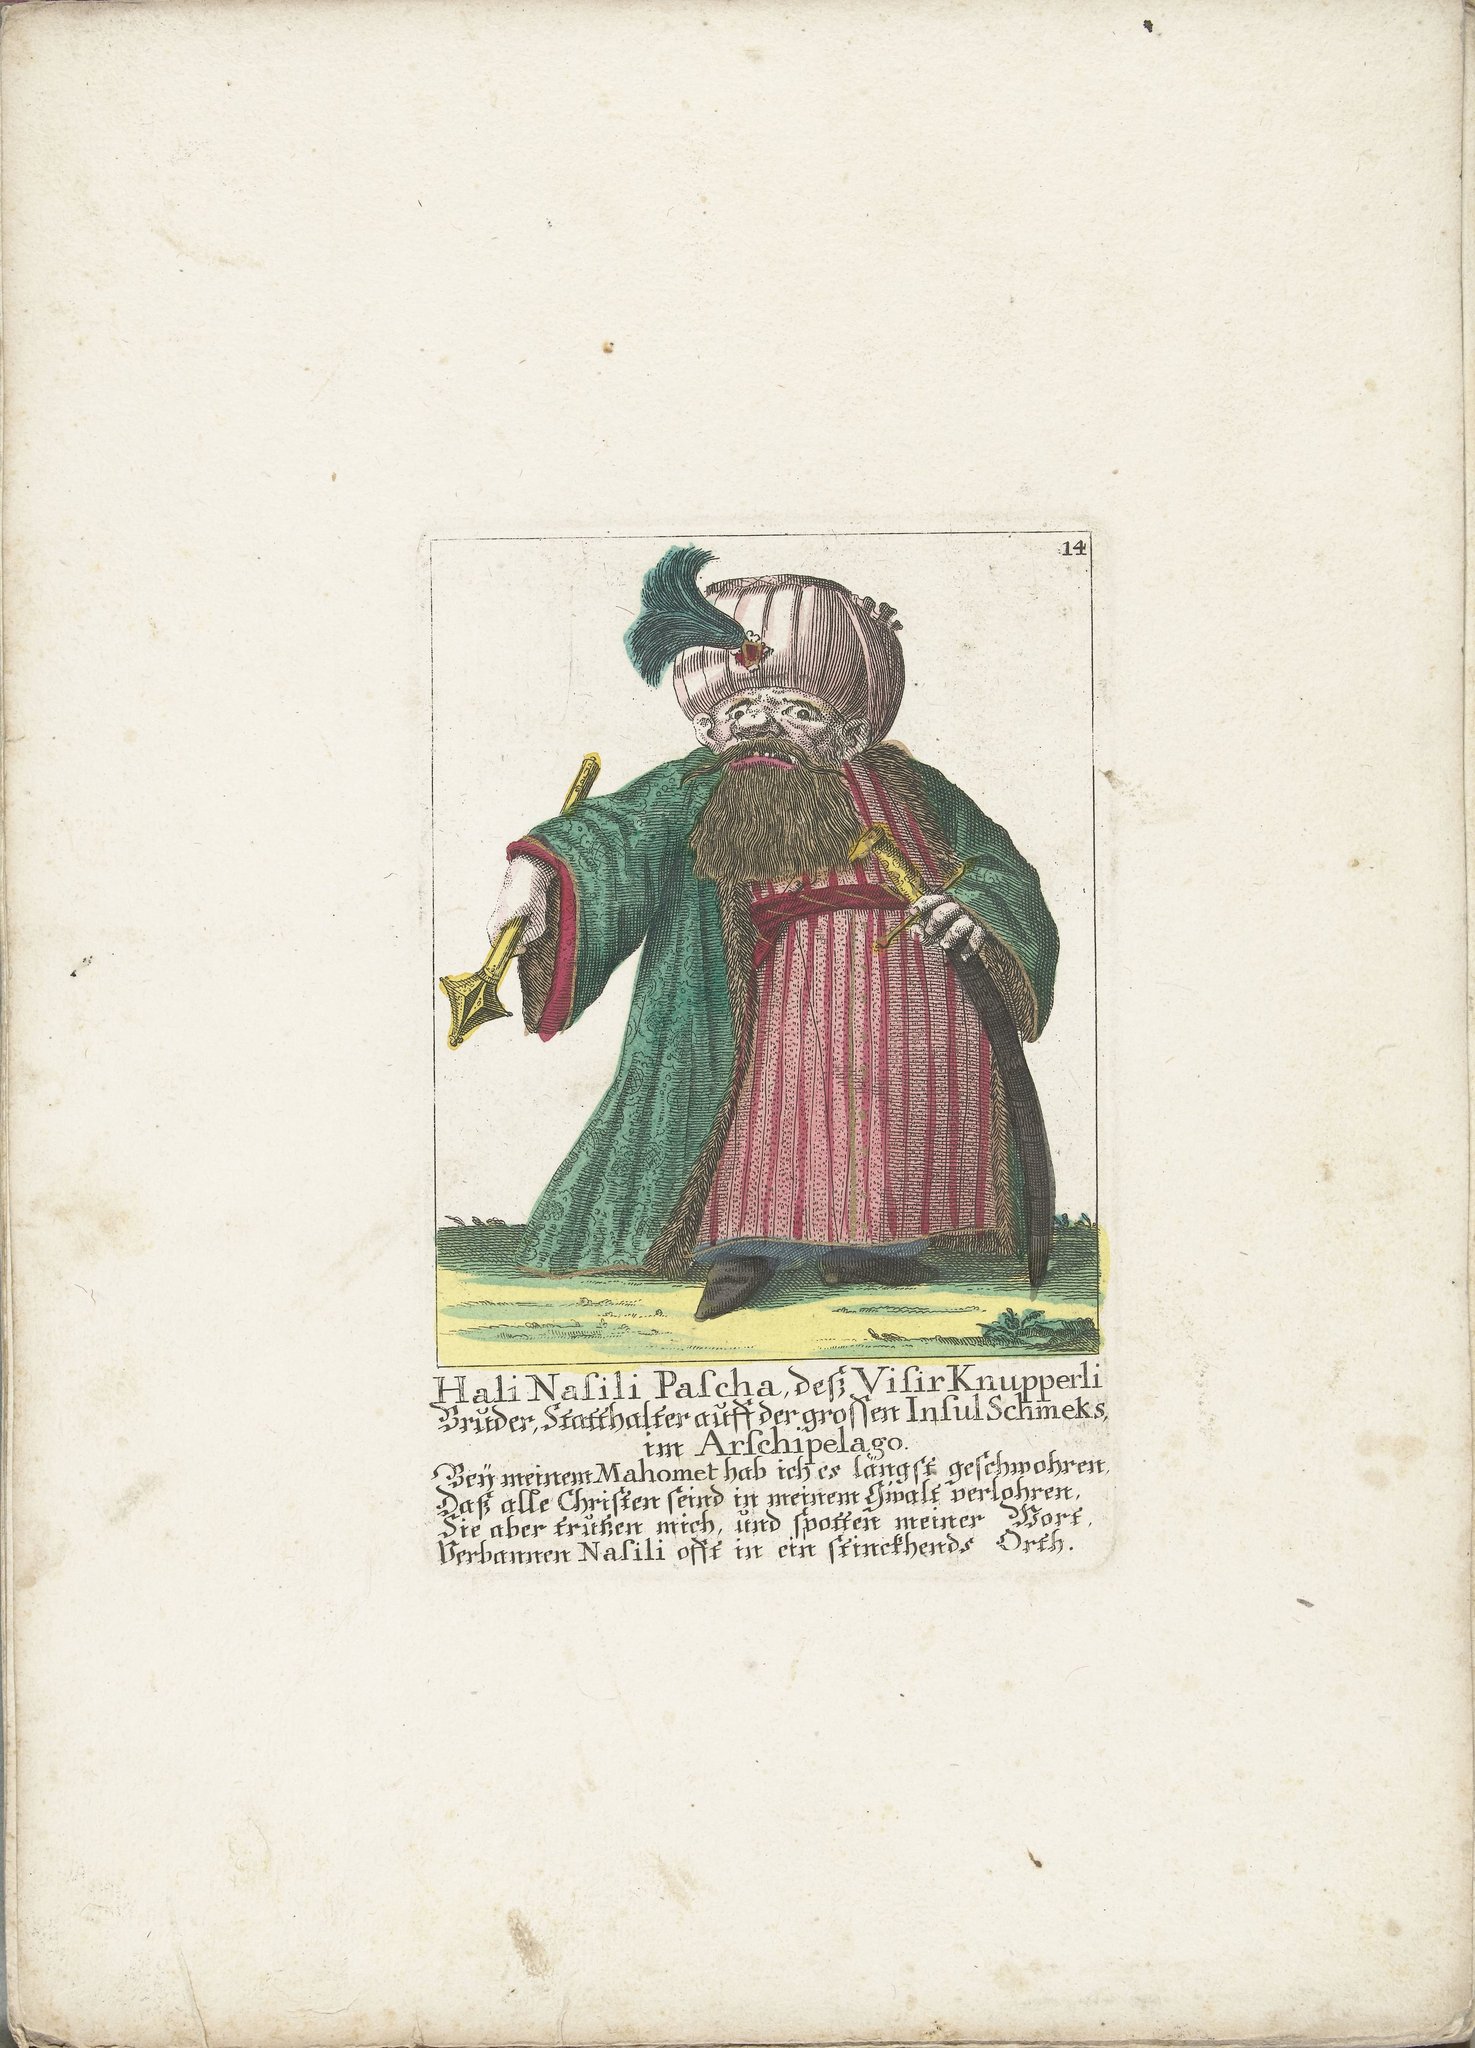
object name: caricature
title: Hali Nasili Pascha, deß Visir Knupperli Bruder, Statthalter auff der grossen Insul Schmeks im Arschipelago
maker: martin engelbrecht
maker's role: print maker, publisher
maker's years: 1684-1756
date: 1705-1715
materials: paper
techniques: engraving, etching, hand coloring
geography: augsburg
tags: caricatures (human types), little people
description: De moslim kleine mens Hali Nasili Pascha, met tulband en scepter in de hand. In het onderschrift onder de titel een vierregelig vers in het Duits. Genummerd rechtsboven: 14. Onderdeel van een losbladige uitgave uit ca. 1710 van een serie karikaturen van kleine mensen, bekend als Het Dwergentooneel.